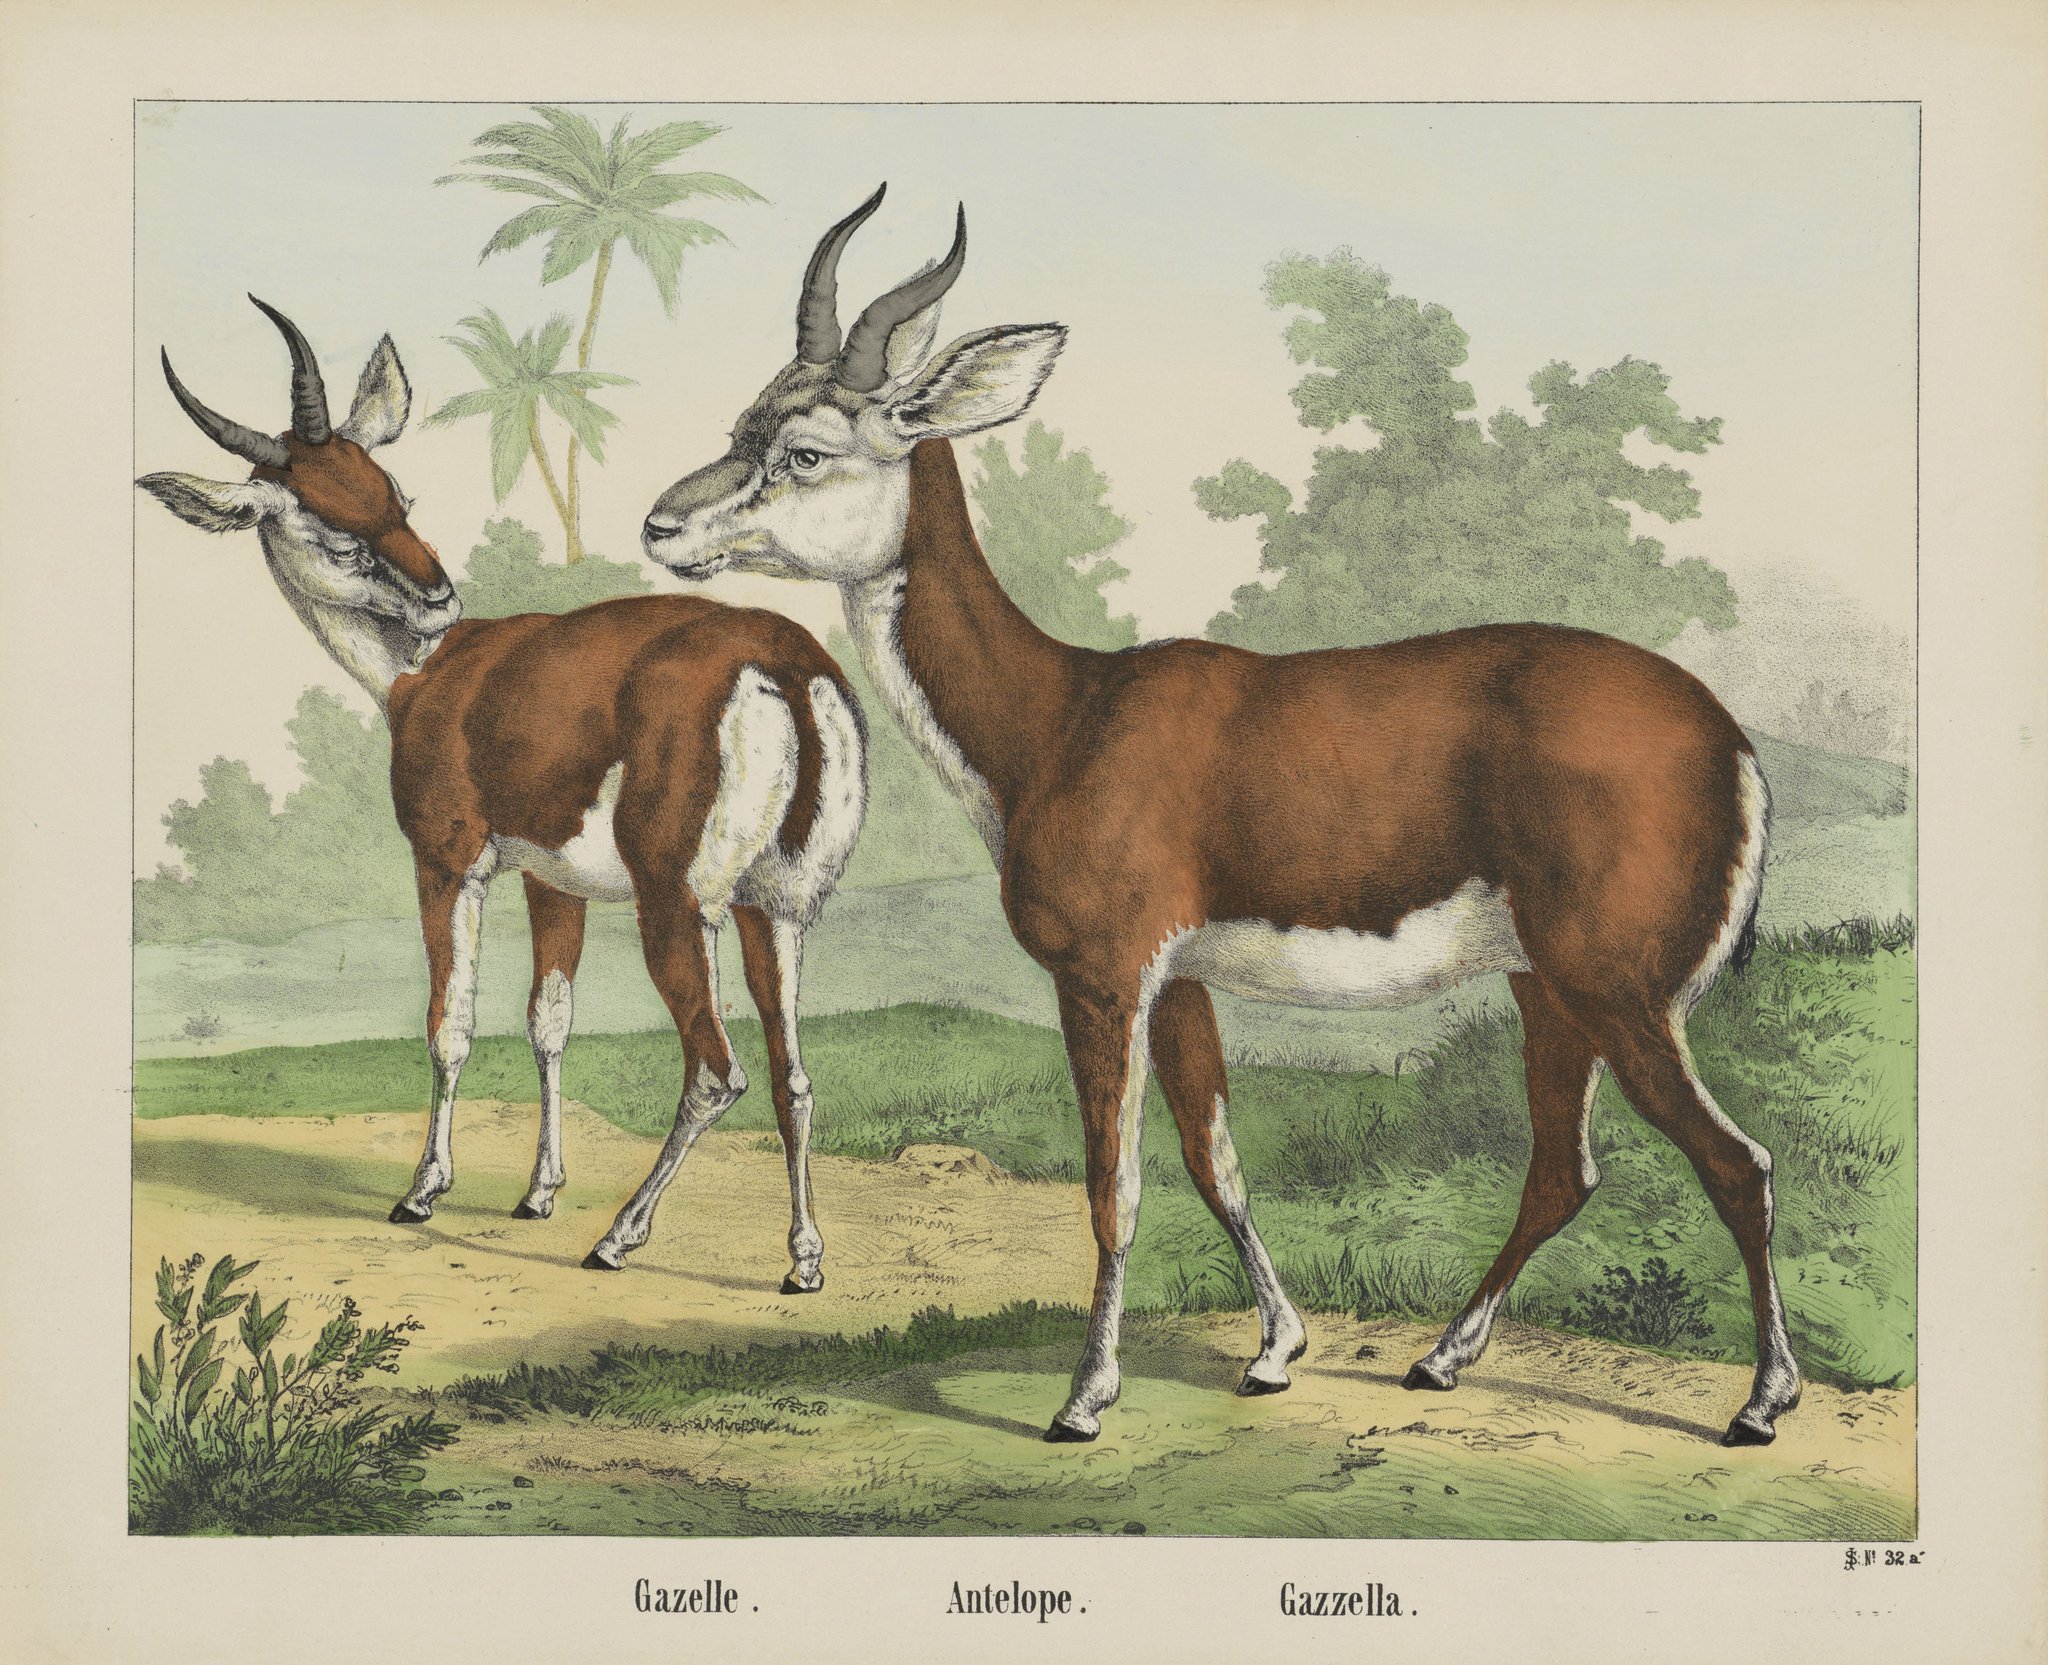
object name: print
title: Gazelle. / Antelope. / Gazella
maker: Anonymous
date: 1829-1880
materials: paper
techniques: colour, letterpress printing, lithograph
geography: europe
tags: hoofed animals: gazelle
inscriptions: collector's mark: Lugt 2760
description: Twee gazellen in een graslandschap met bomen op de achtergrond. Genummerd rechtsonder: No. 32a.